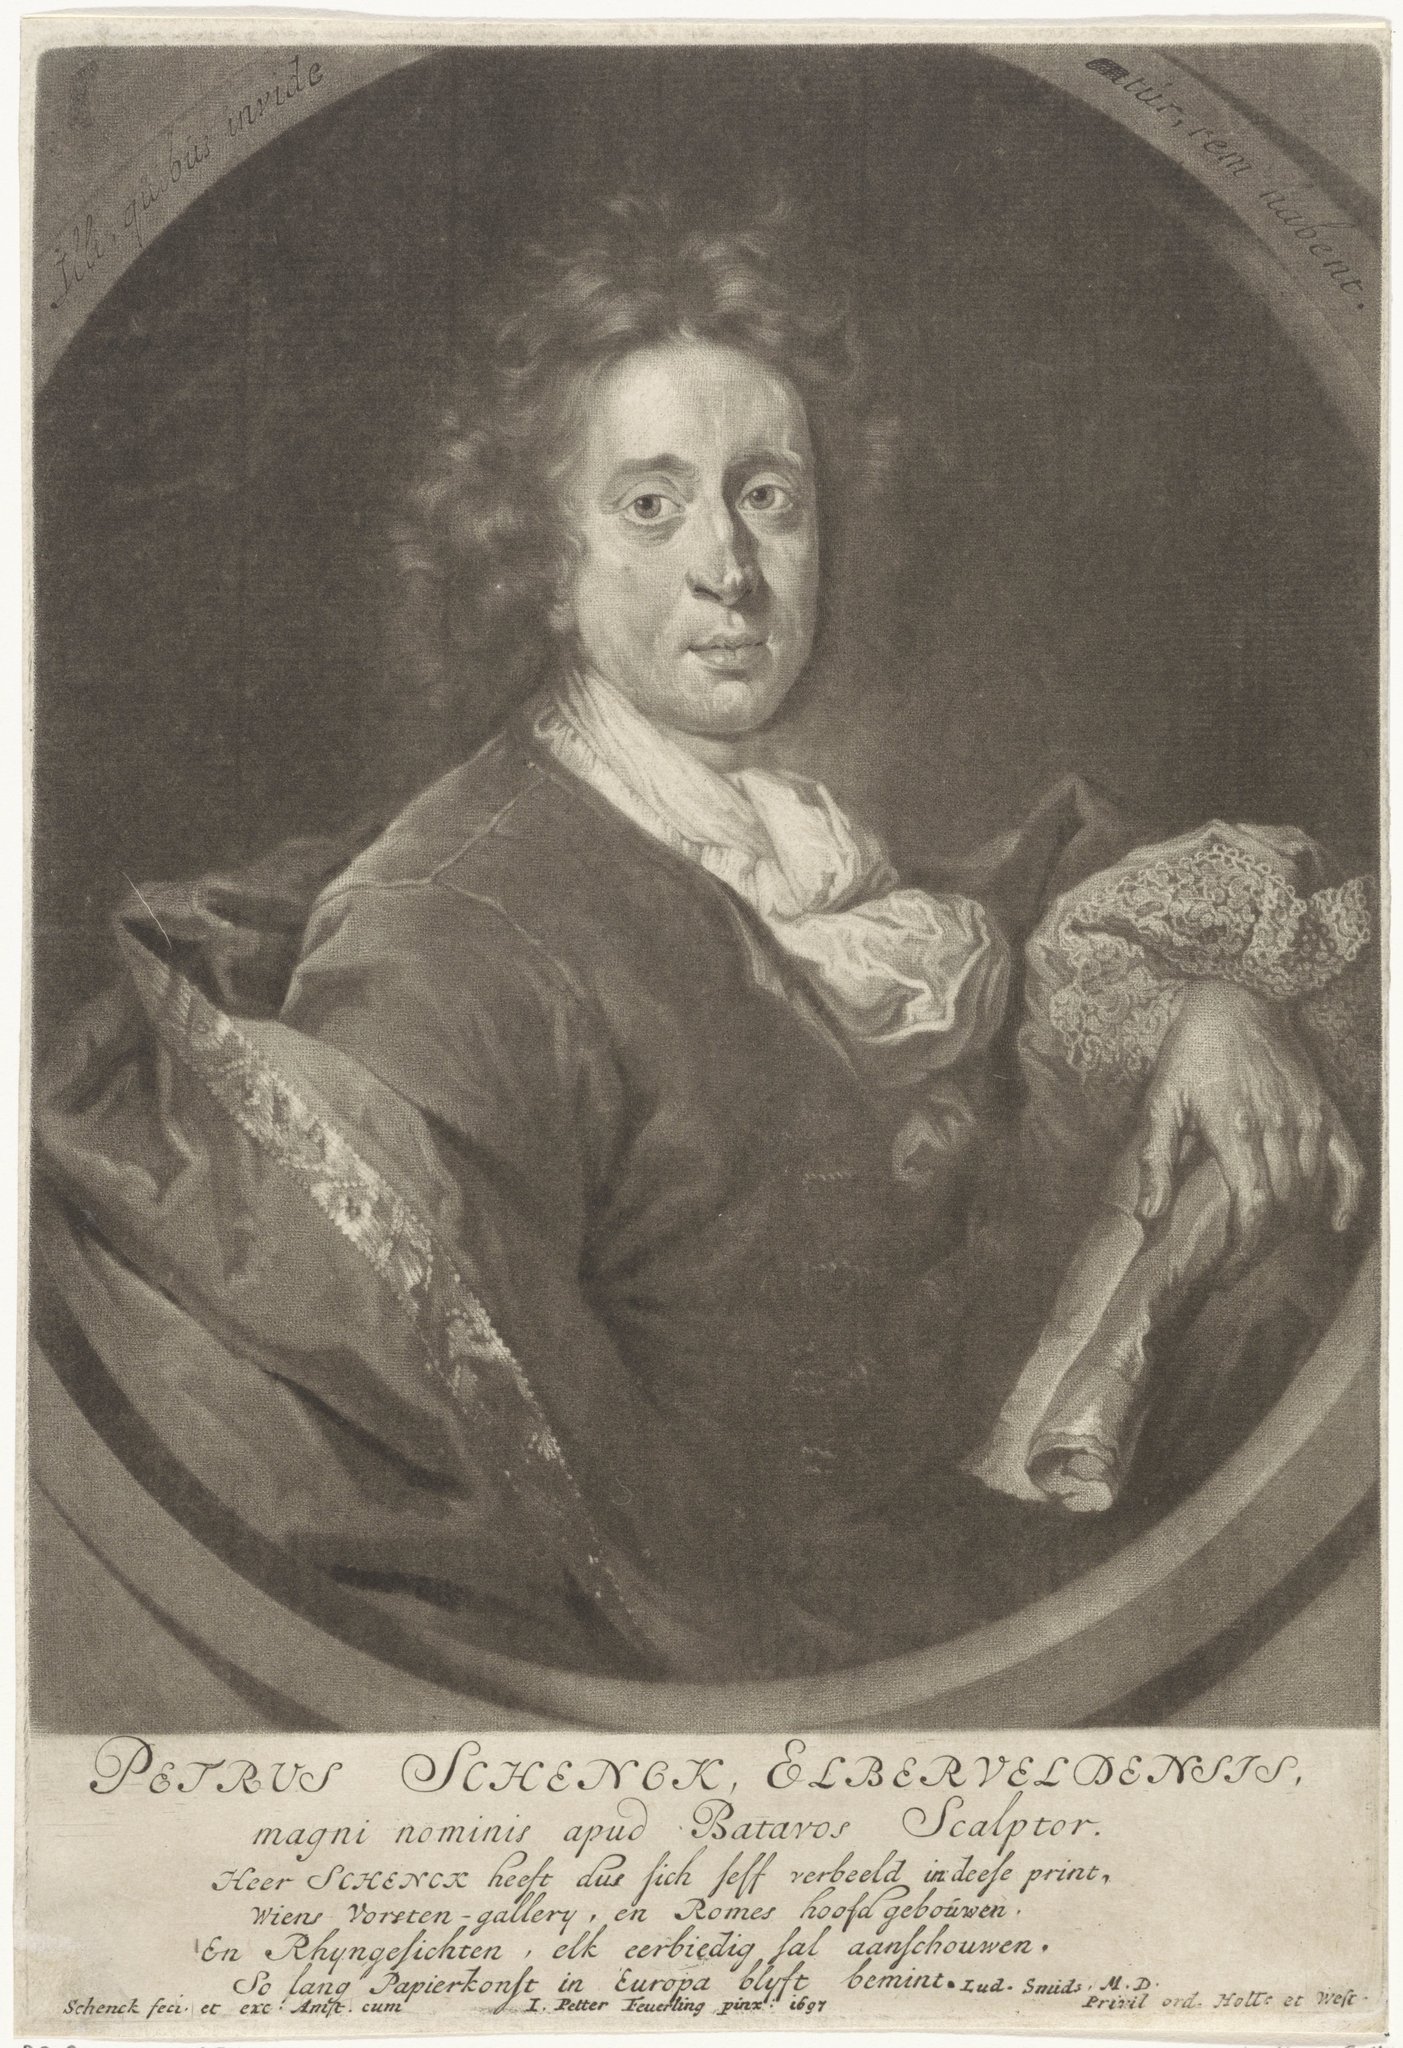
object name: print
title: Zelfportret van Pieter Schenk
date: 1697-1713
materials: paper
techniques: engraving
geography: amsterdam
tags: print maker, pieter schenk (i), portrait, self-portrait of painter, letter, envelope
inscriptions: collector's mark: Lugt 2228, collector's mark: Lugt 2760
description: De prentmaker en uitgever Pieter Schenk met opgerold papier in de hand.